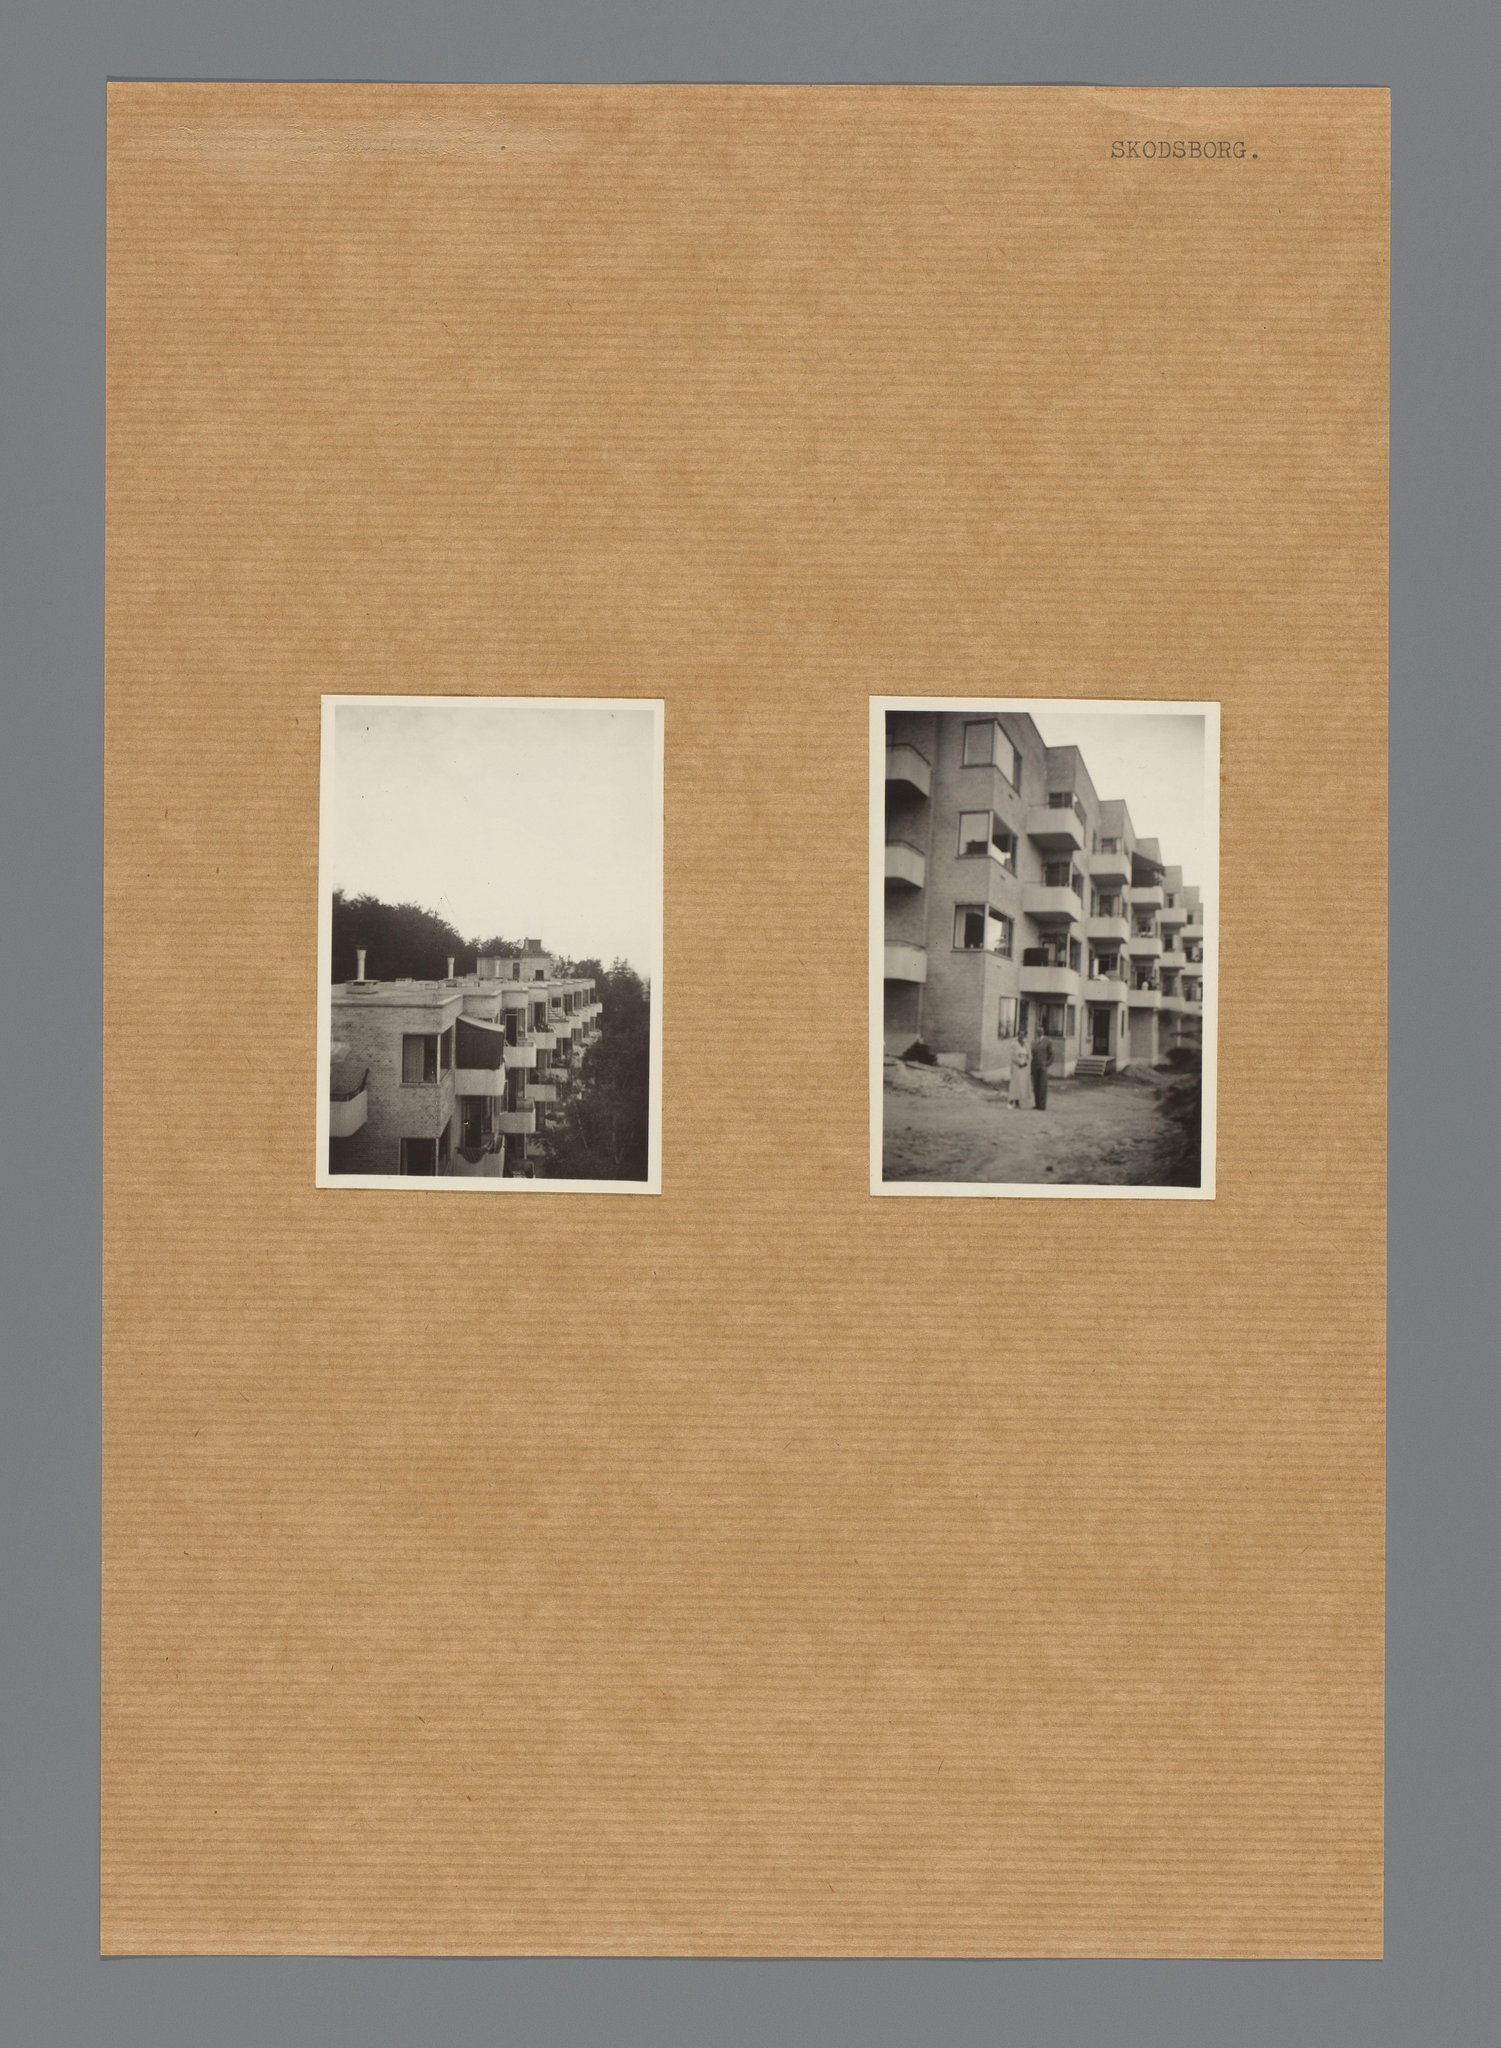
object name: photograph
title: Skodsborg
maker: Anonymous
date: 1880-1920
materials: photographic support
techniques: gelatin silver print